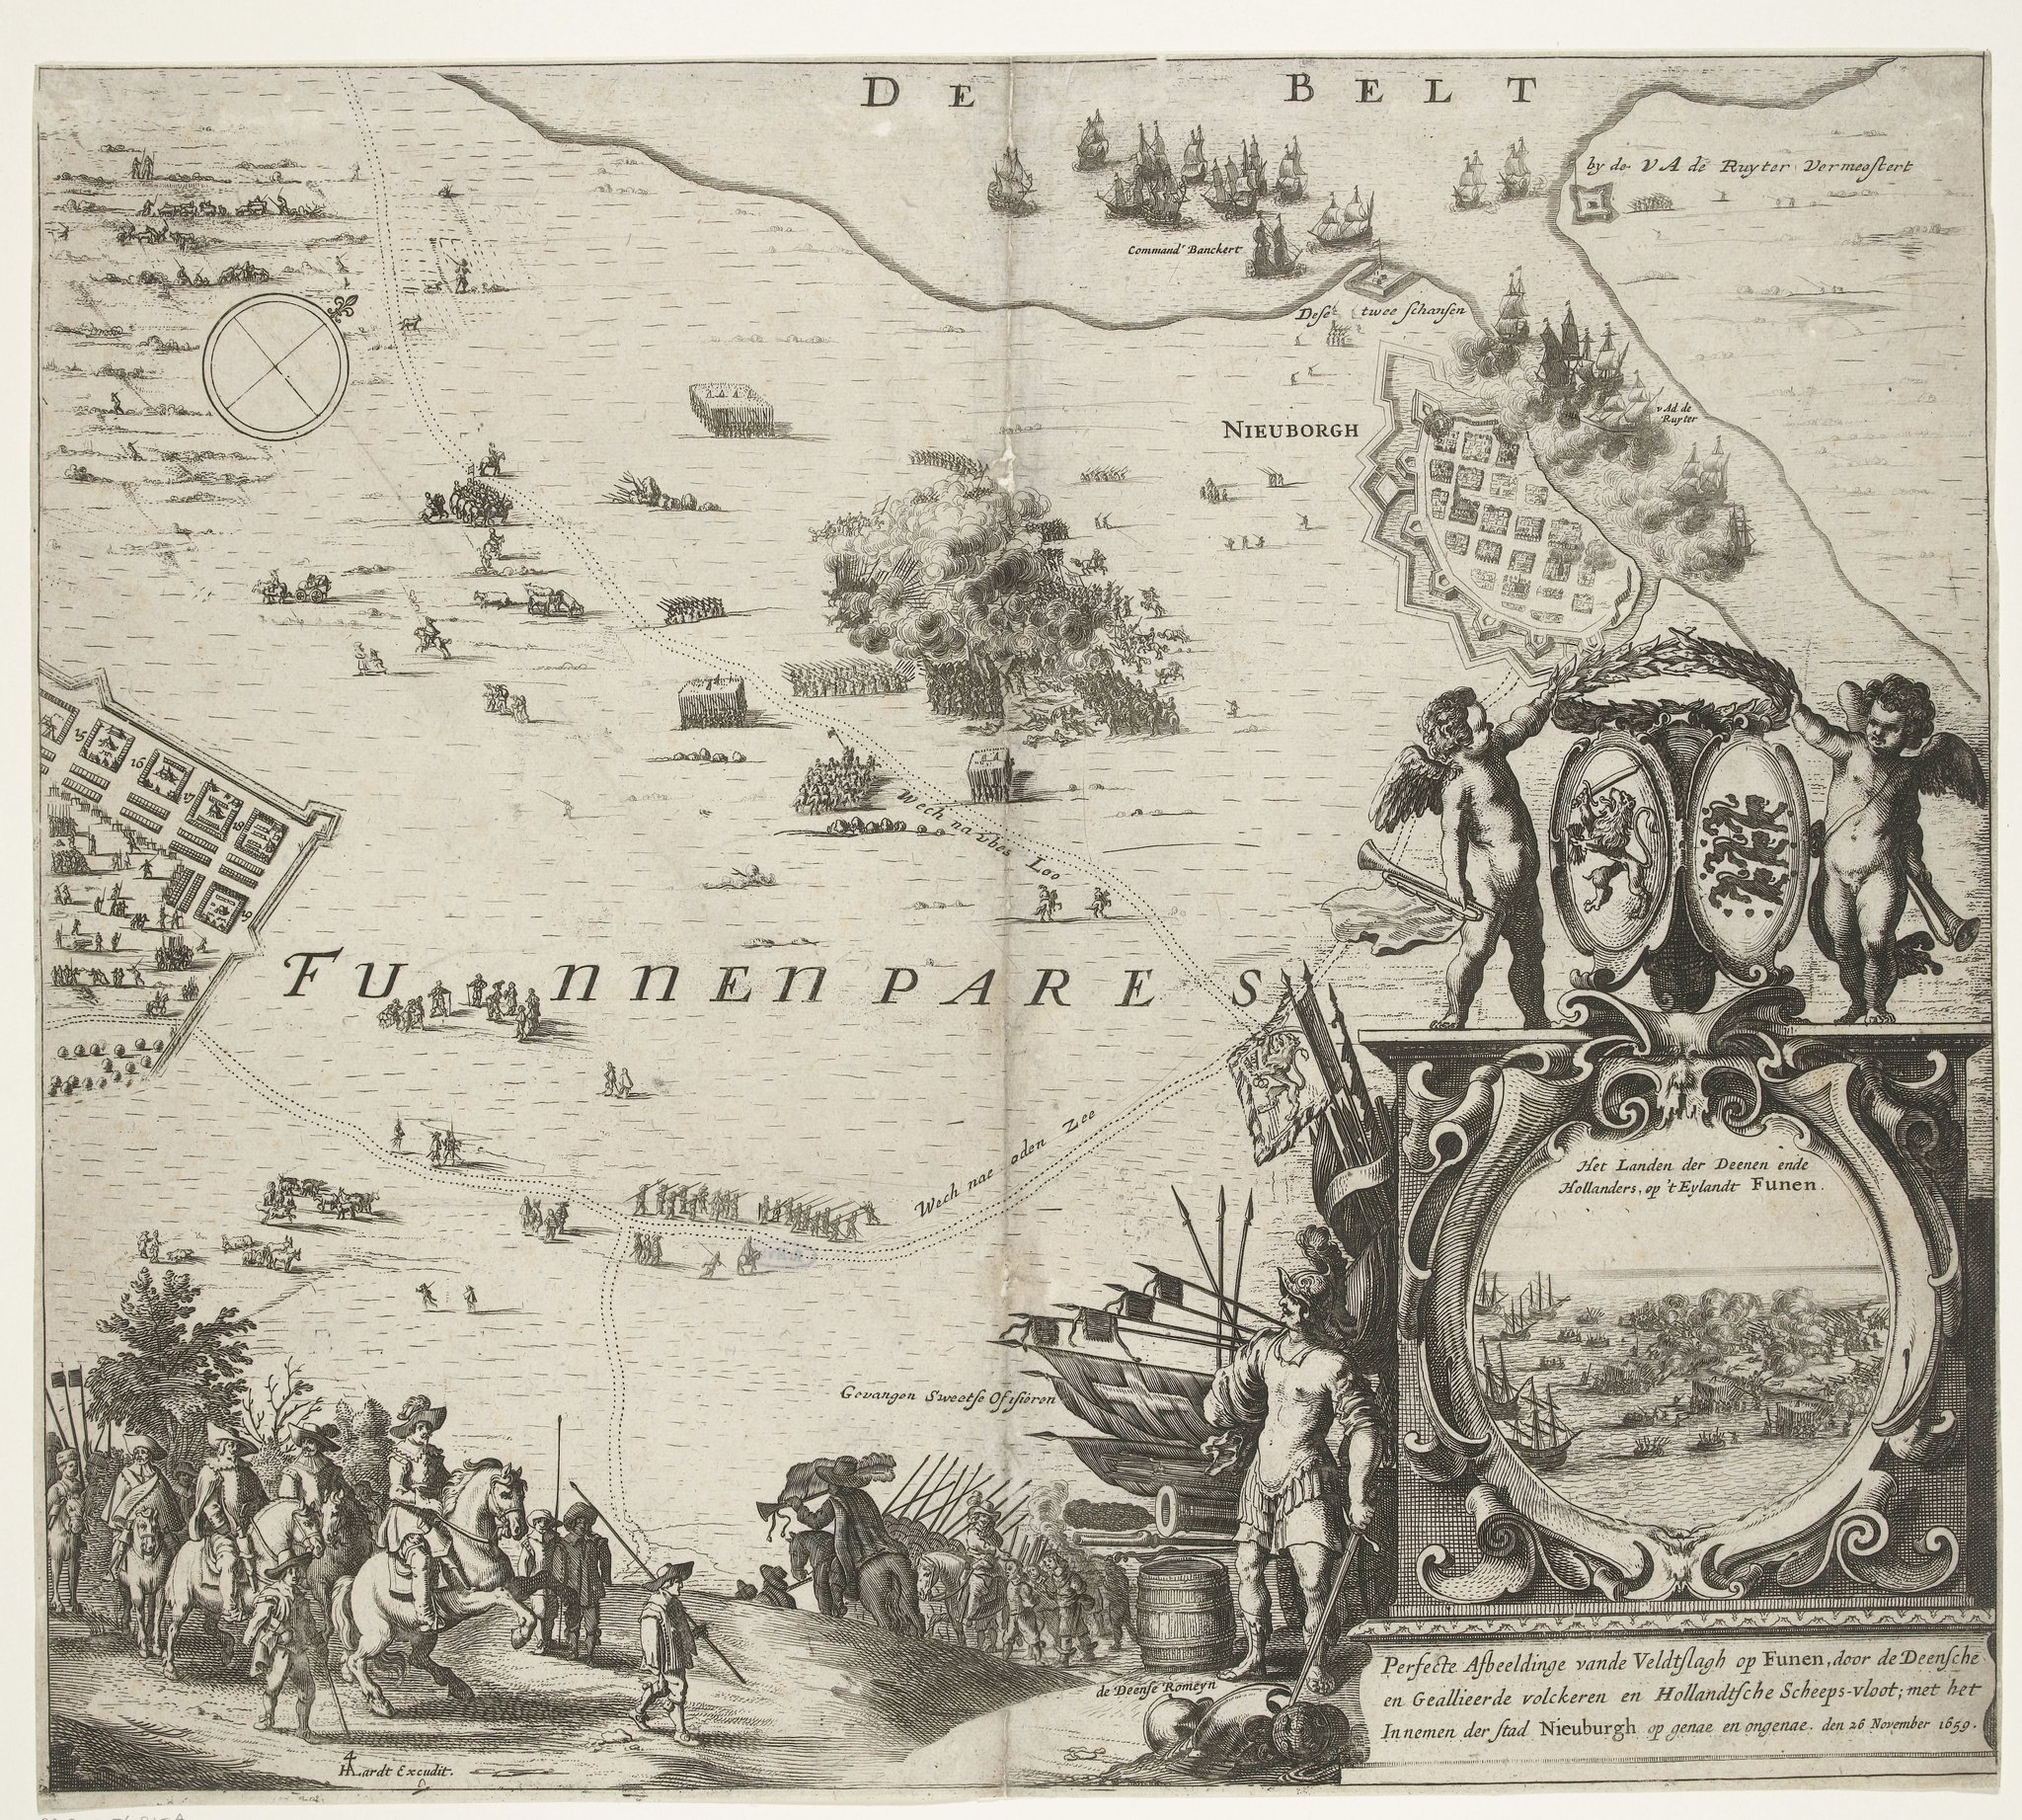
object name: print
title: Nederlaag der Zweden op Funen, 26 november 1659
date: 1659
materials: paper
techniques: engraving, etching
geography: amsterdam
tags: flushing, michiel adriaenszoon de ruyter, maps of separate countries or regions, warfare; military affairs (+ marines), warfare; military affairs (+ landing, disembarkation of armed forces), battle (+ land forces)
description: Inname van de stad Nyborg door Michiel Adriaenszoon de Ruyter en het verslaan van het Zweedse leger door de Denen, 25-26 november 1659. Kaart van het deel van het eiland Funen met een plattegrond van de stad met haven. Rechtsonder een grote cartouche met de landing van de Denen en de Hollanders op het eiland Funen. De cartouche versierd met trofee van wapens en vaandels, bovenop twee putti met de wapens van de Republiek en Denemarken. Op de voorgrond soldaten. Bij de prent behoort een tekstblad.